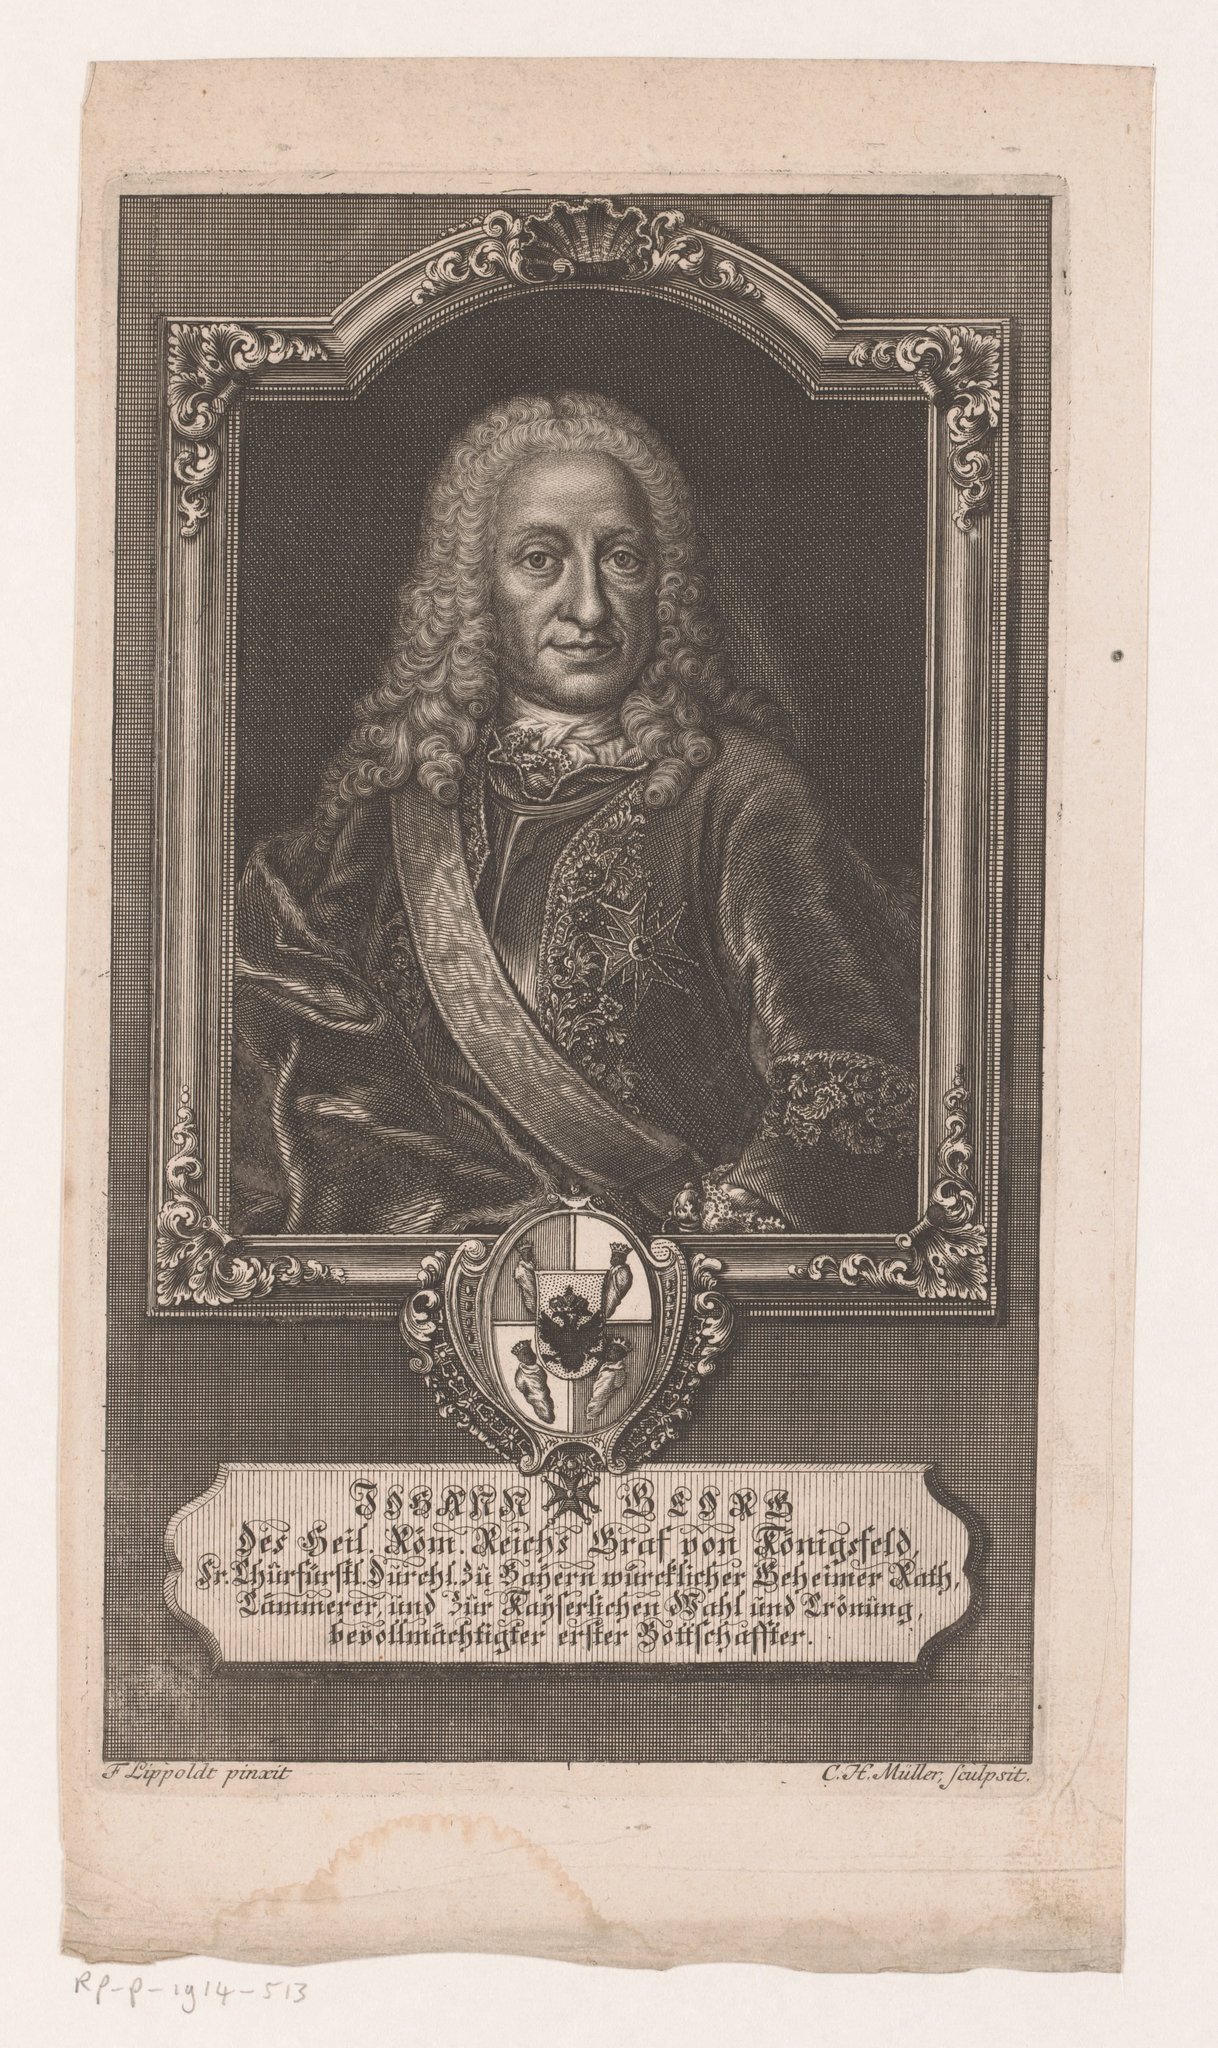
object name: print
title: Portret van George II, koning van Engeland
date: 1727-1799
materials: paper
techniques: engraving, etching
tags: armour, historical persons, medals and other marks of military honour, armorial bearing, heraldry, insignia and symbols of sovereignty (crown, diadem, sceptre, orb, seal, standard, cloak, pectoral)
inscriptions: collector's mark: Lugt 2228